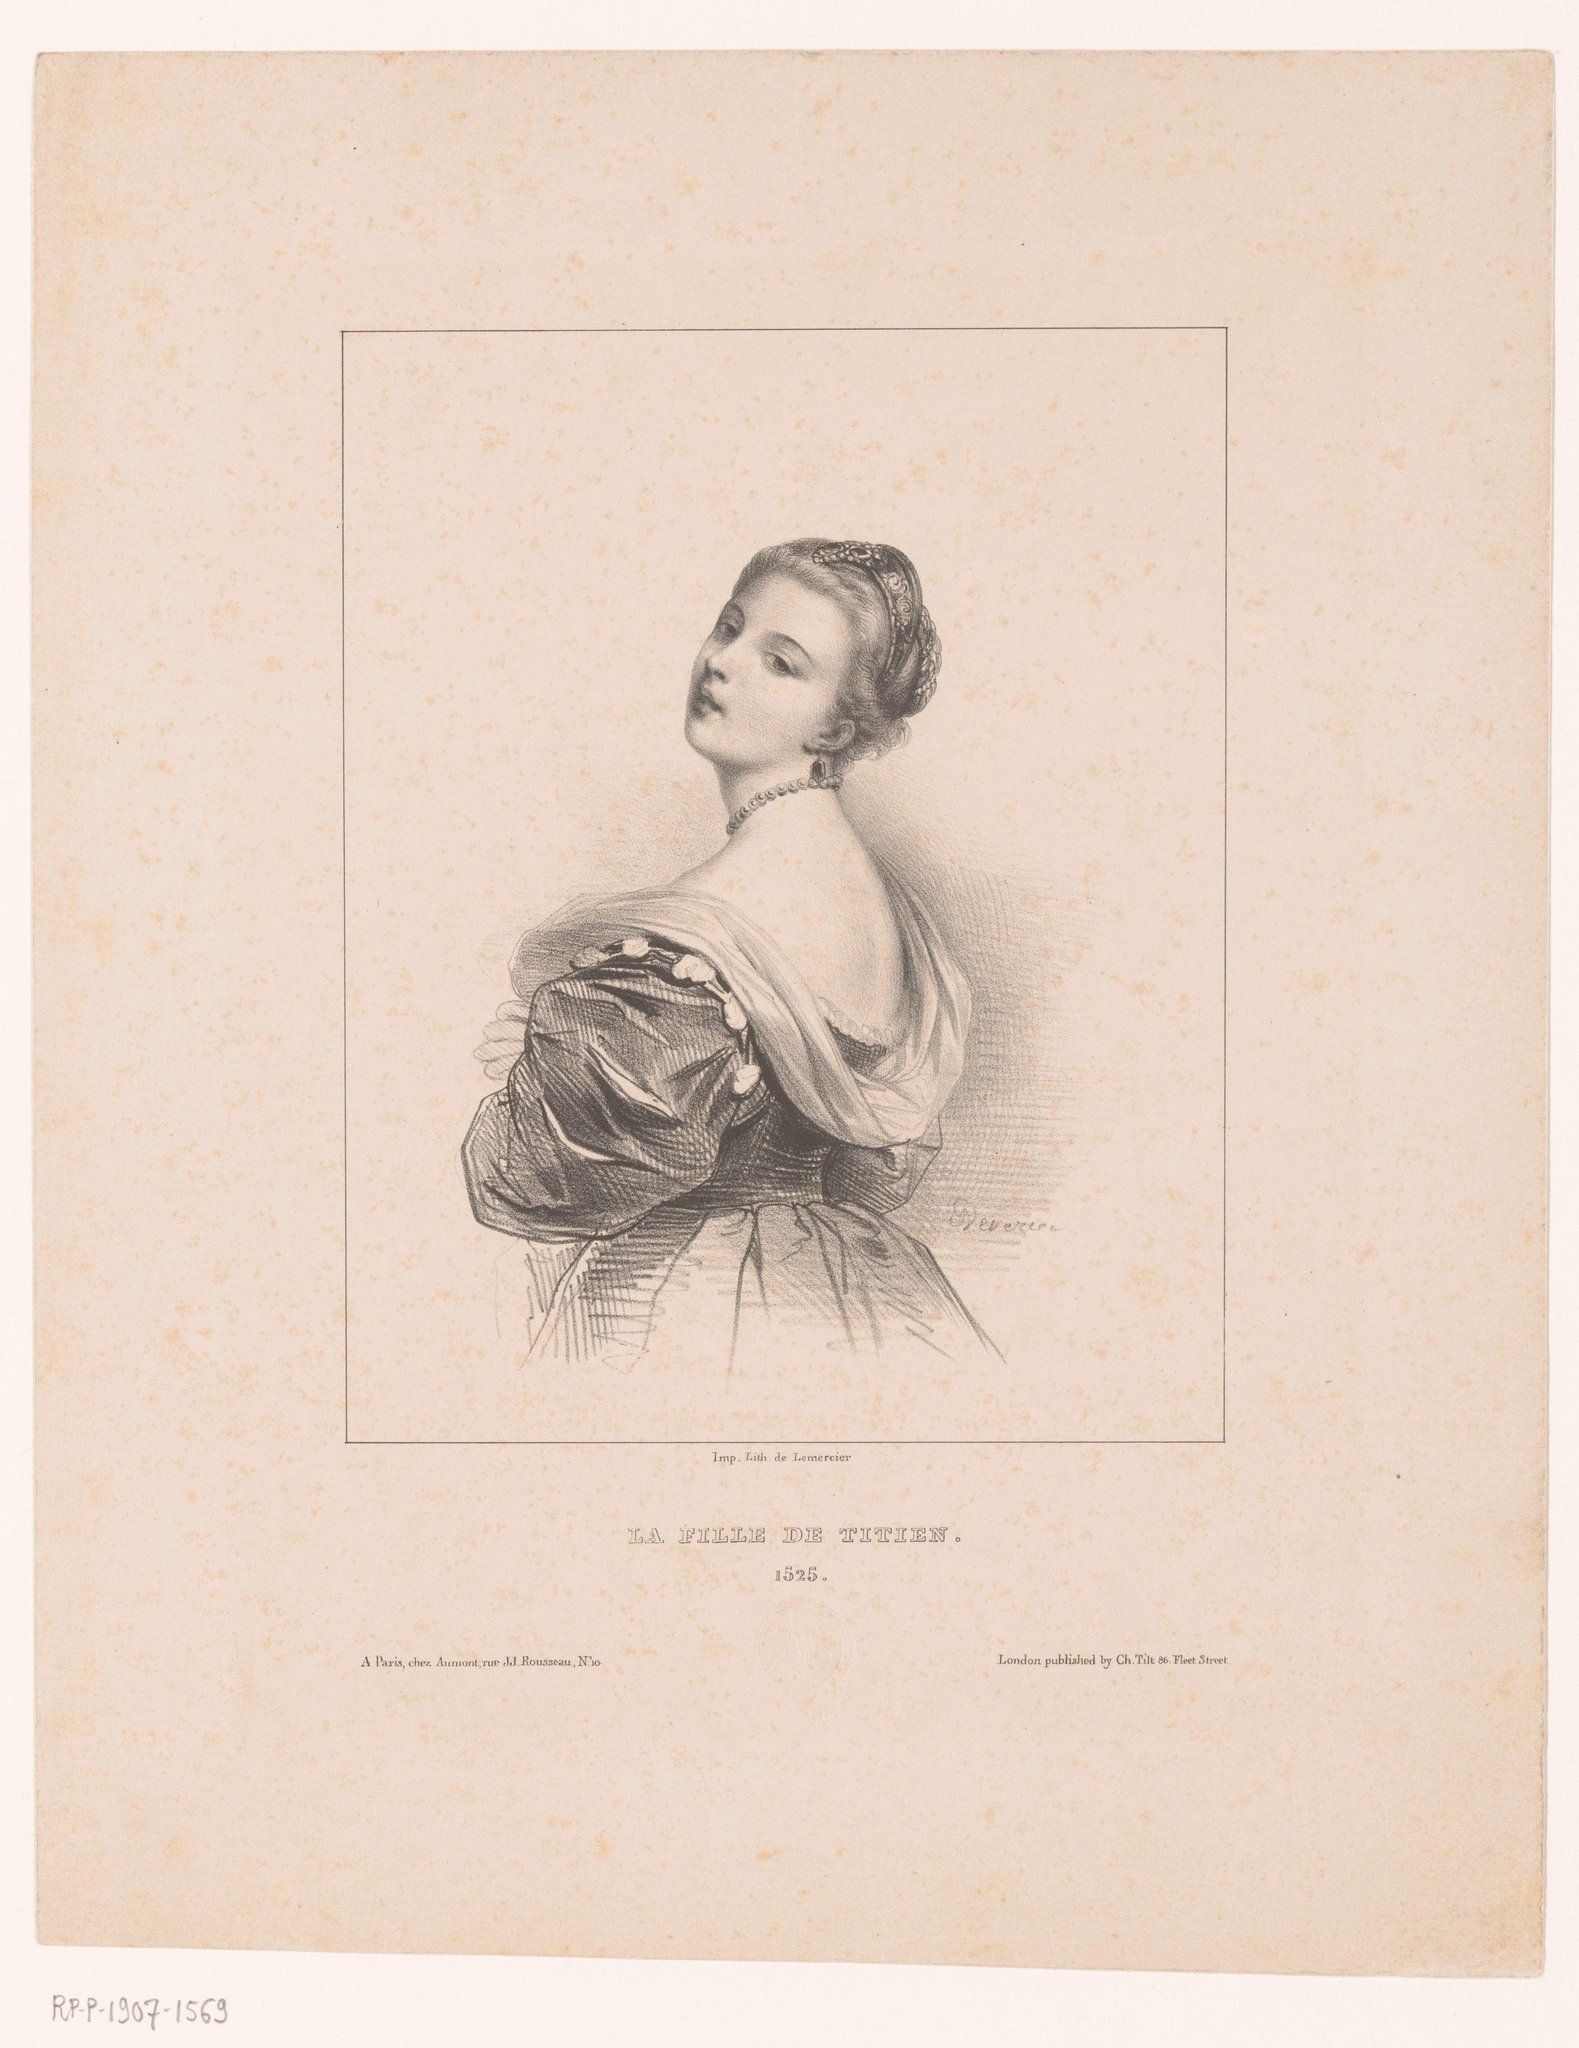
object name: print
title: Portret van Cecilia Soldano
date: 1832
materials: paper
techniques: lithograph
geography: paris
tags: artist's model, sitter, historical persons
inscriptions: collector's mark: Lugt 2228a, check stamp: Lugt 88b